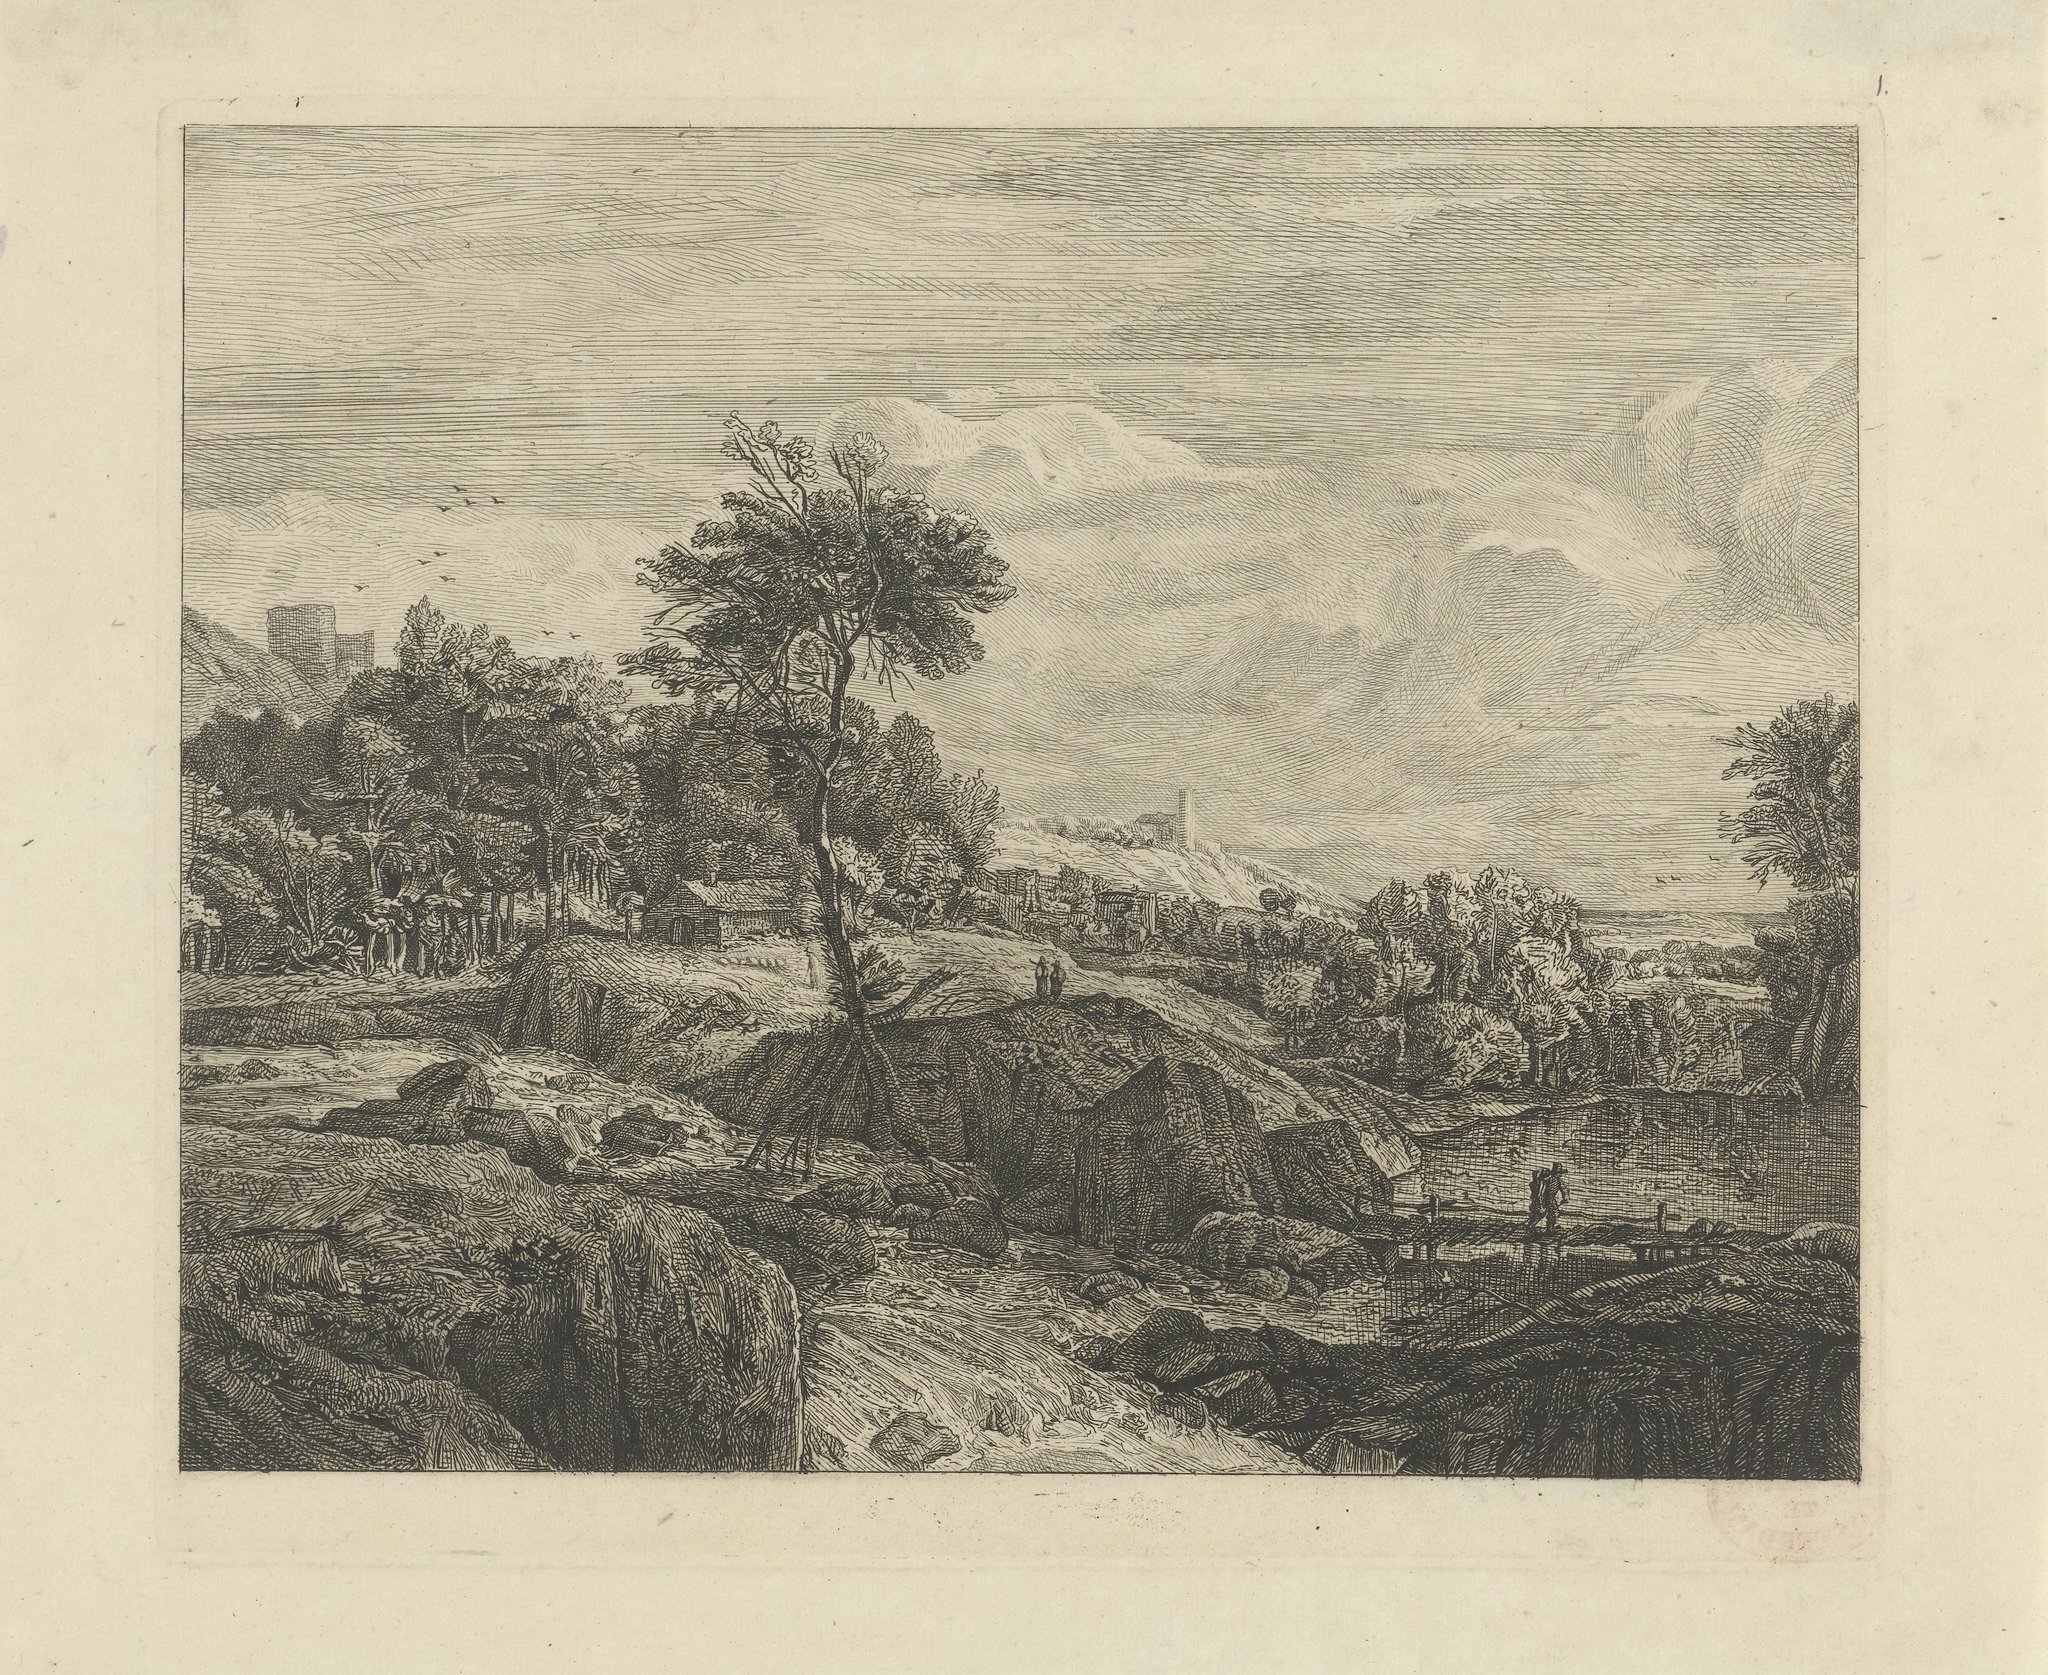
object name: print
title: Rotsachtig landschap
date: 1801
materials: paper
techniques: etching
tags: rocks - hh - ideal landscapes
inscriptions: collector's mark: Lugt 12, number: ‘1’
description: Landschap met rotsen en een stromende beek. Iets links van het midden staat een boom, rechts loopt een figuur over een brug.